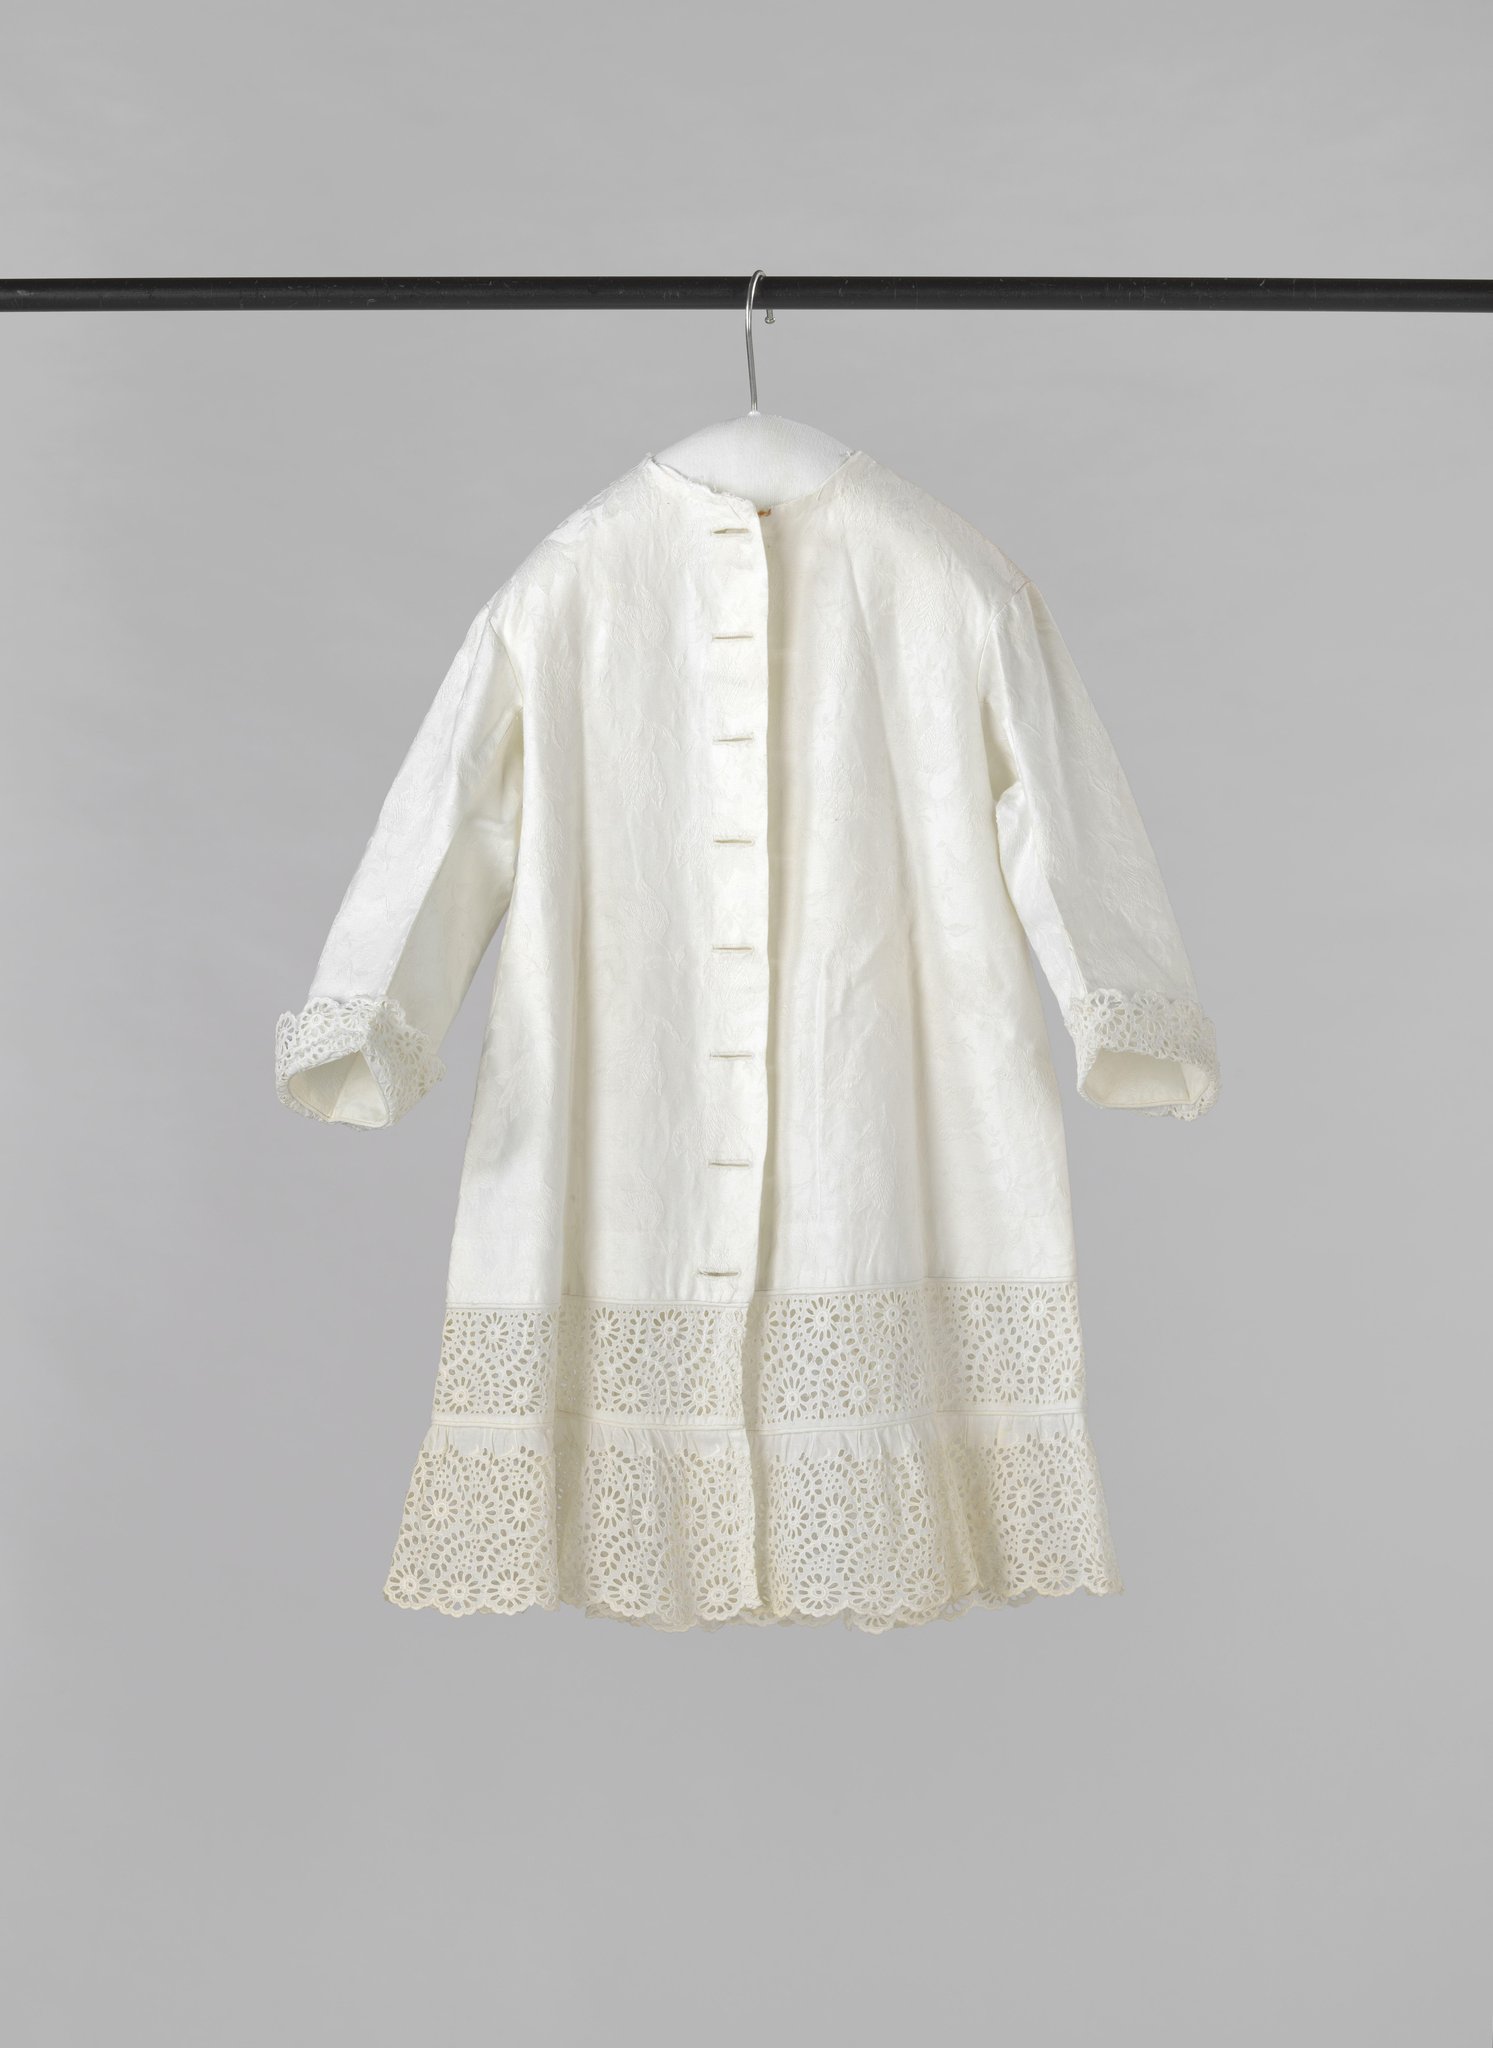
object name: coat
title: Jas voor een kind van katoenen damast en versierd met Engels borduurwerk.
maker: Anonymous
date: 1880-1890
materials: cotton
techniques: damask, embroidered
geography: netherlands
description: Jas voor een kind van katoenen damast en versierd met Engels borduurwerk. Nederland, ca. 1885.